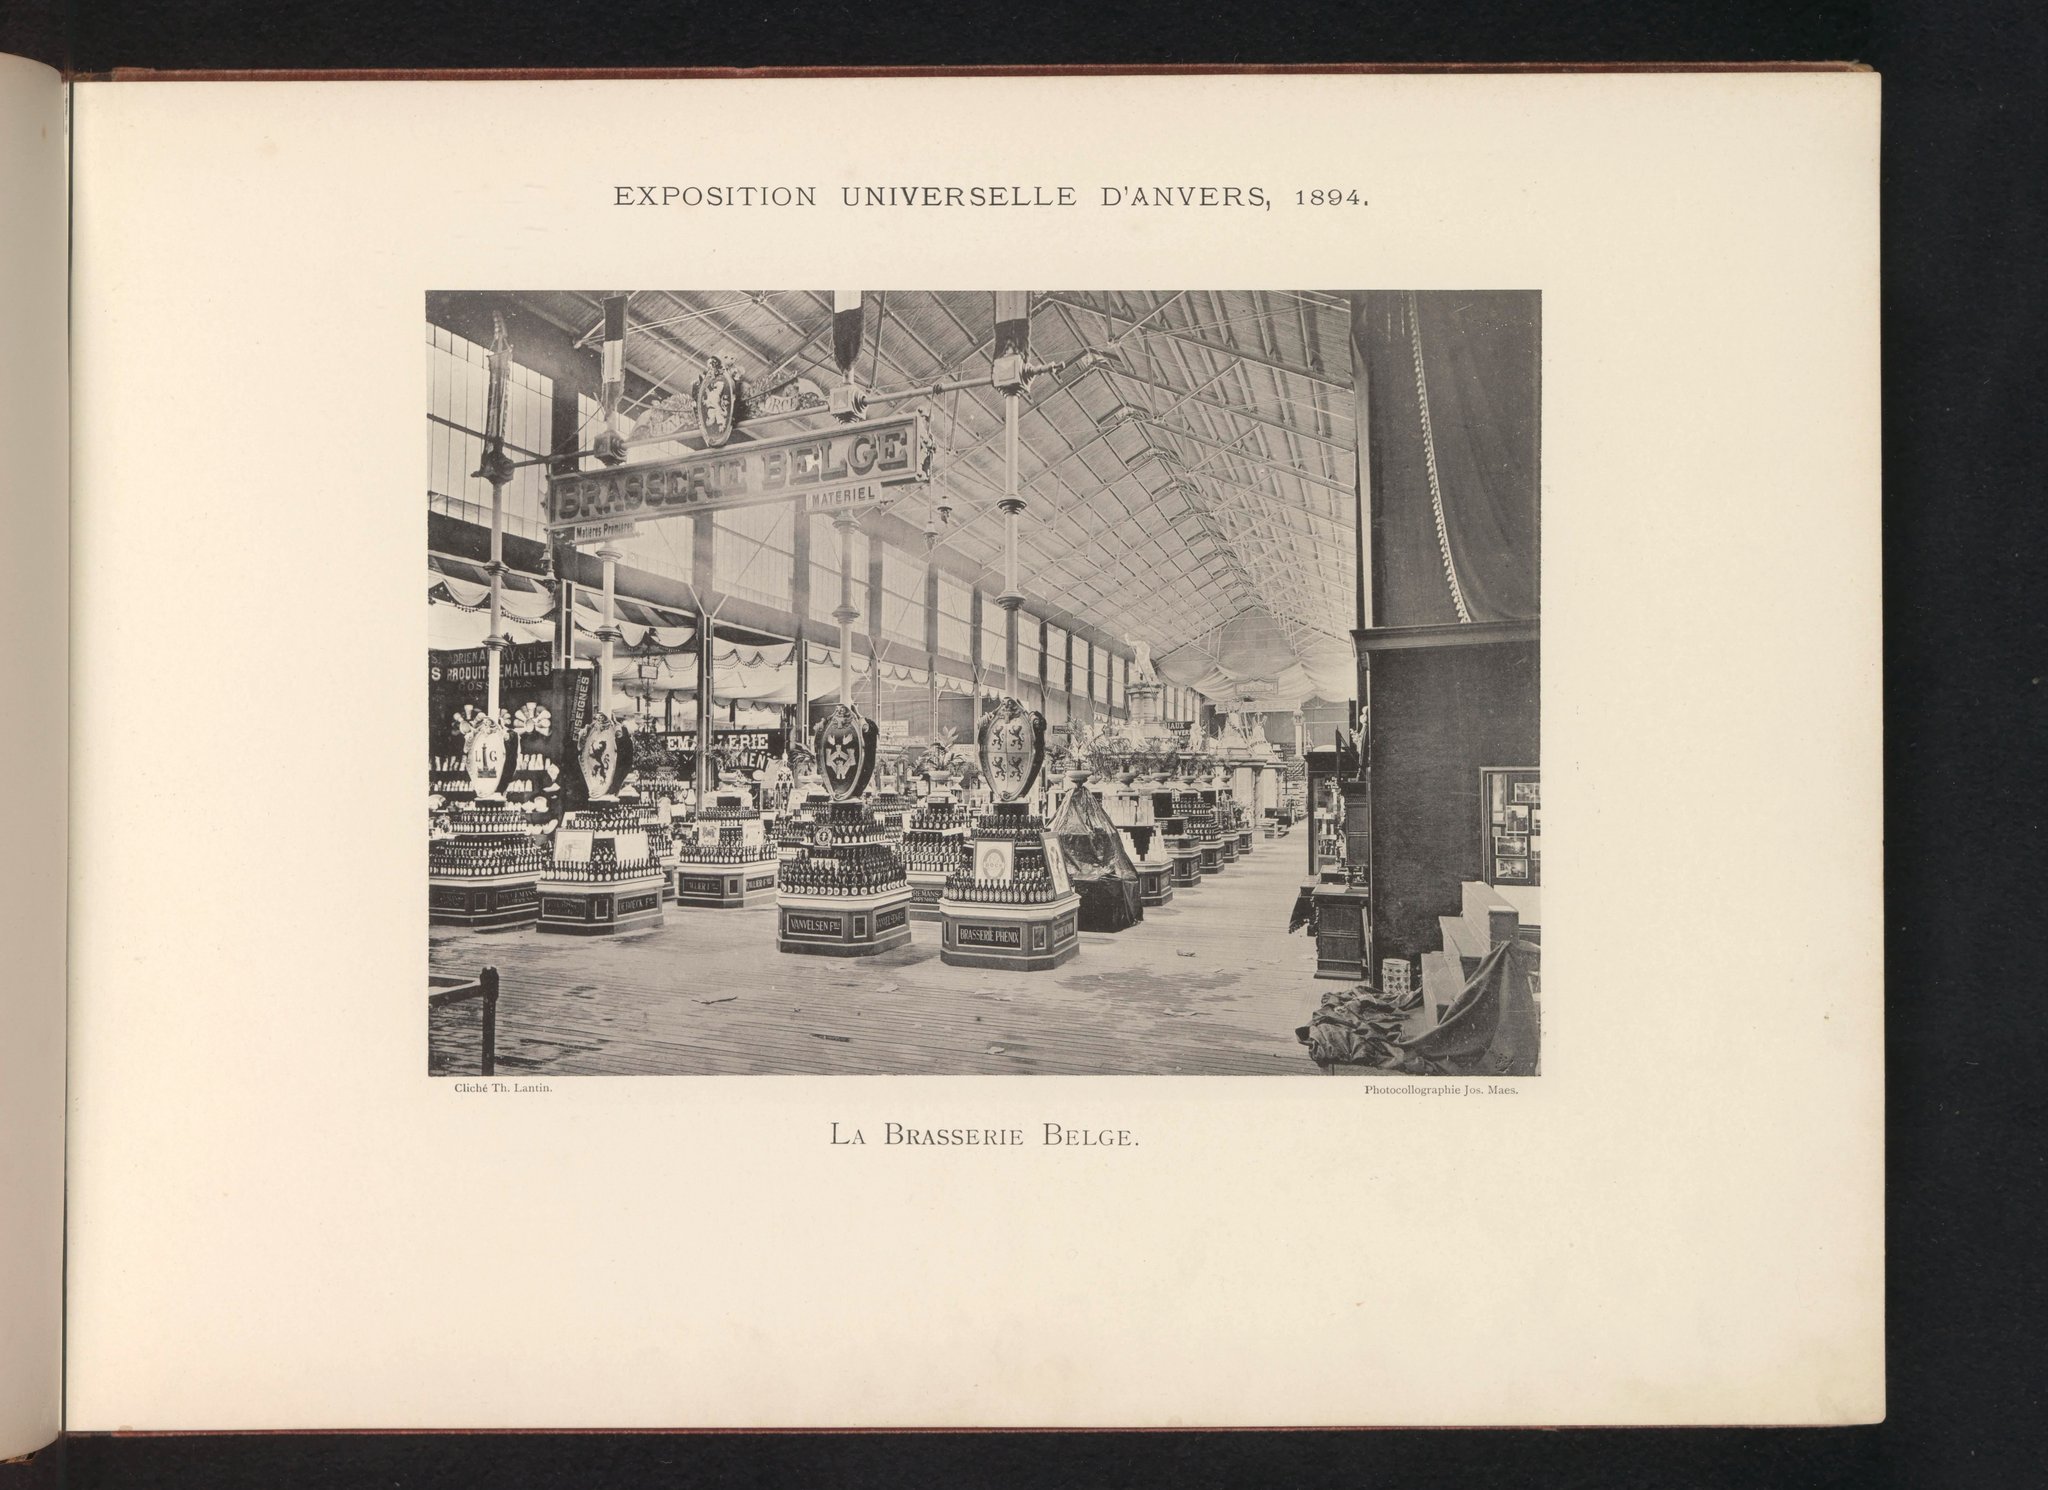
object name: page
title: Expositie van Belgische levensmiddelen tijdens de wereldtentoonstelling te Antwerpen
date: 1894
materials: paper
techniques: photograph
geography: antwerp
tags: world fair, world exhibition, industries ~ food, drink, stimulants, collection, exhibition, show